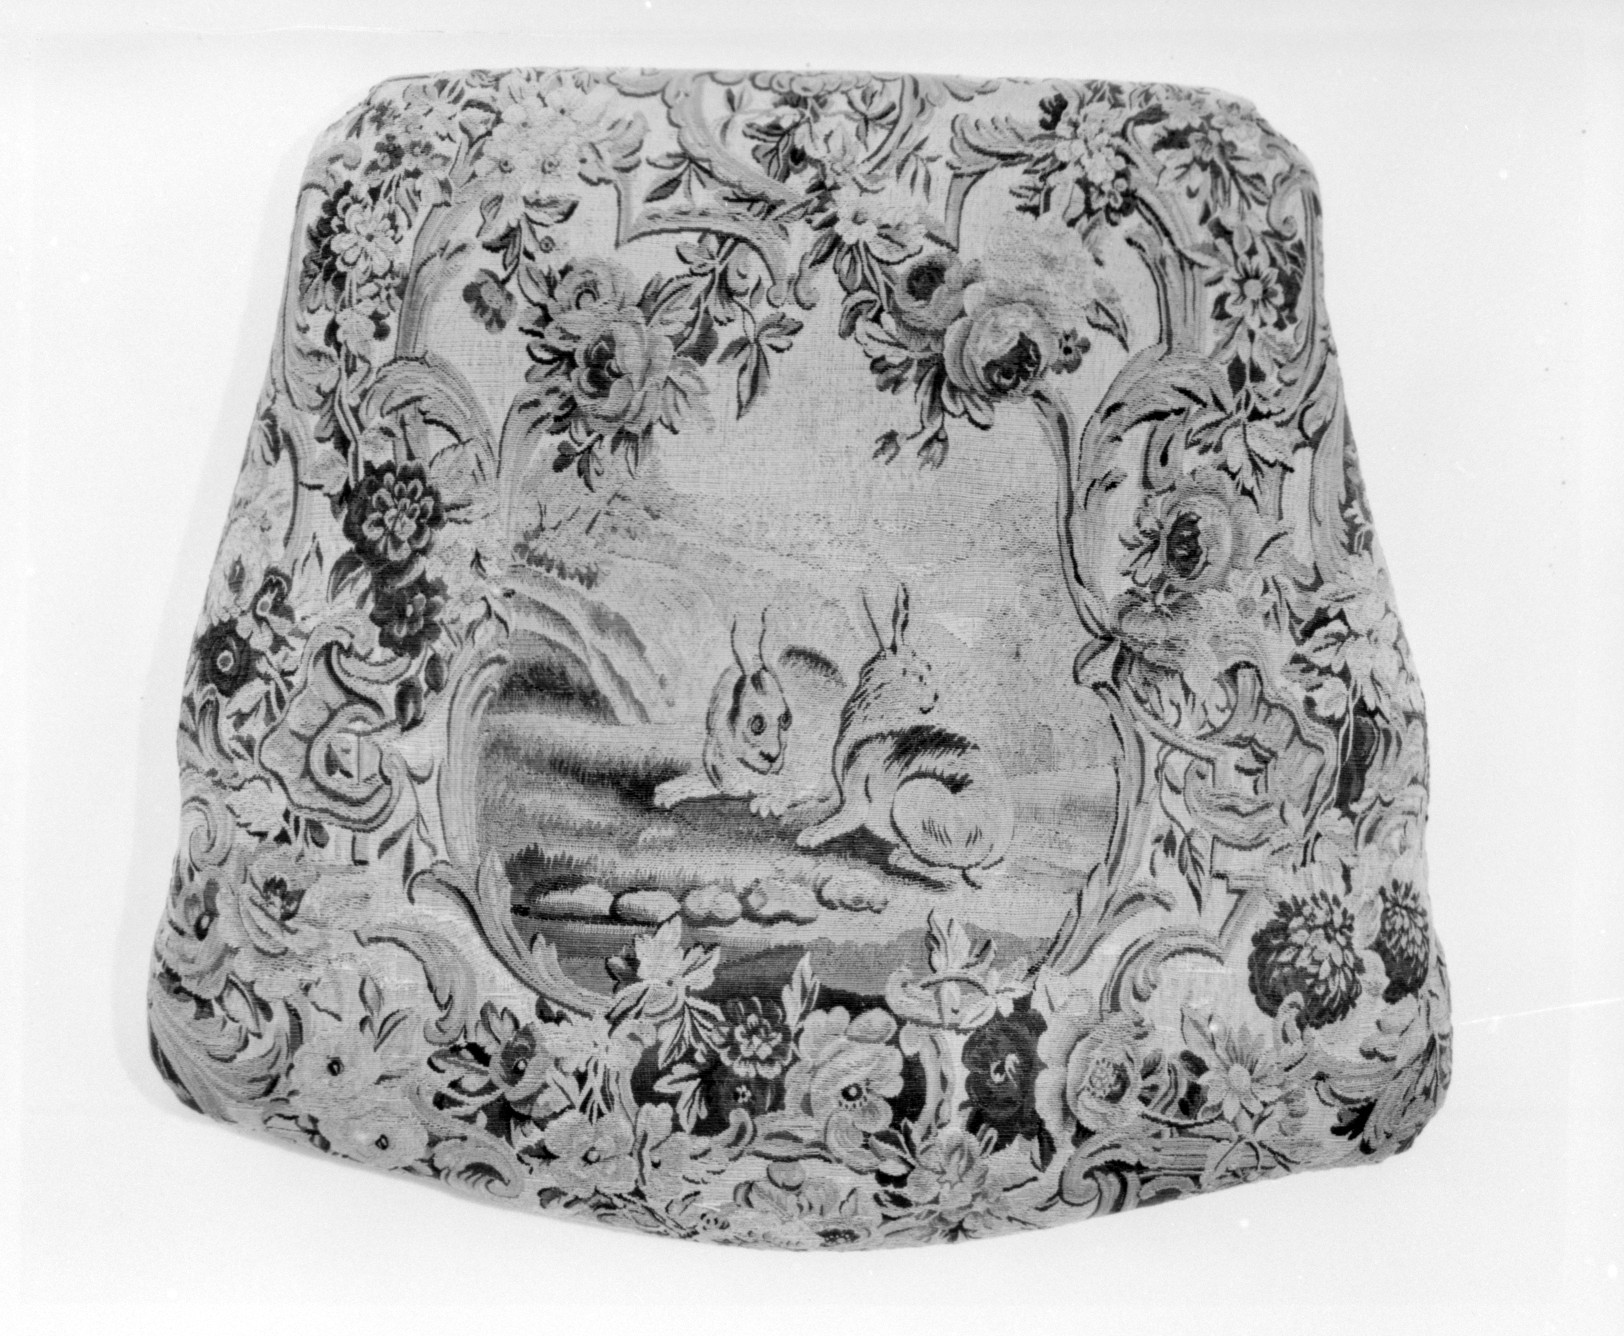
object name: upholstery panel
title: Armchair seat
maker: beauvais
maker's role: manufactory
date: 1754-1756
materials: silk, wool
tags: animals,flowers